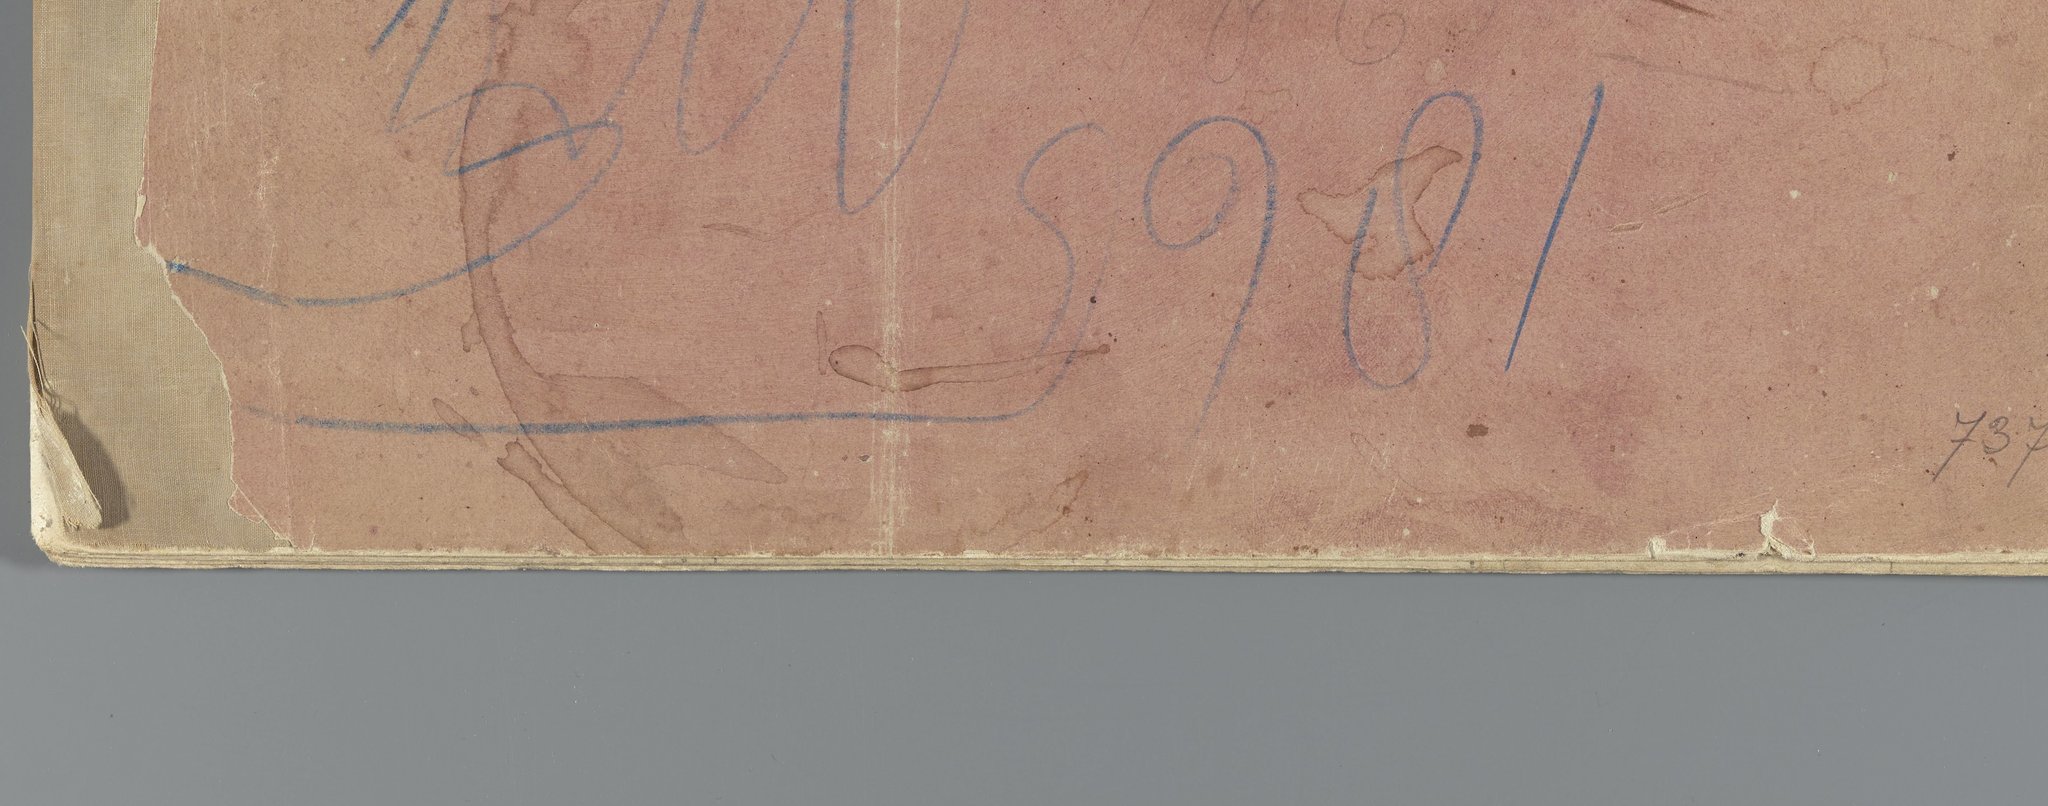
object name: sketchbook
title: Schetsboek van de begrafenis van Anna Paulowna, 1865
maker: Anonymous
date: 1865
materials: paper, pencil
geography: netherlands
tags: anna paulowna romanowa, cortege, funeral procession, delft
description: Schetsboek met een weergave van de begrafenis van wijlen koningin Anna Paulowna te Delft op 17 maart 1865, omslag met tien losse bladen. De bladen los in de omslag.